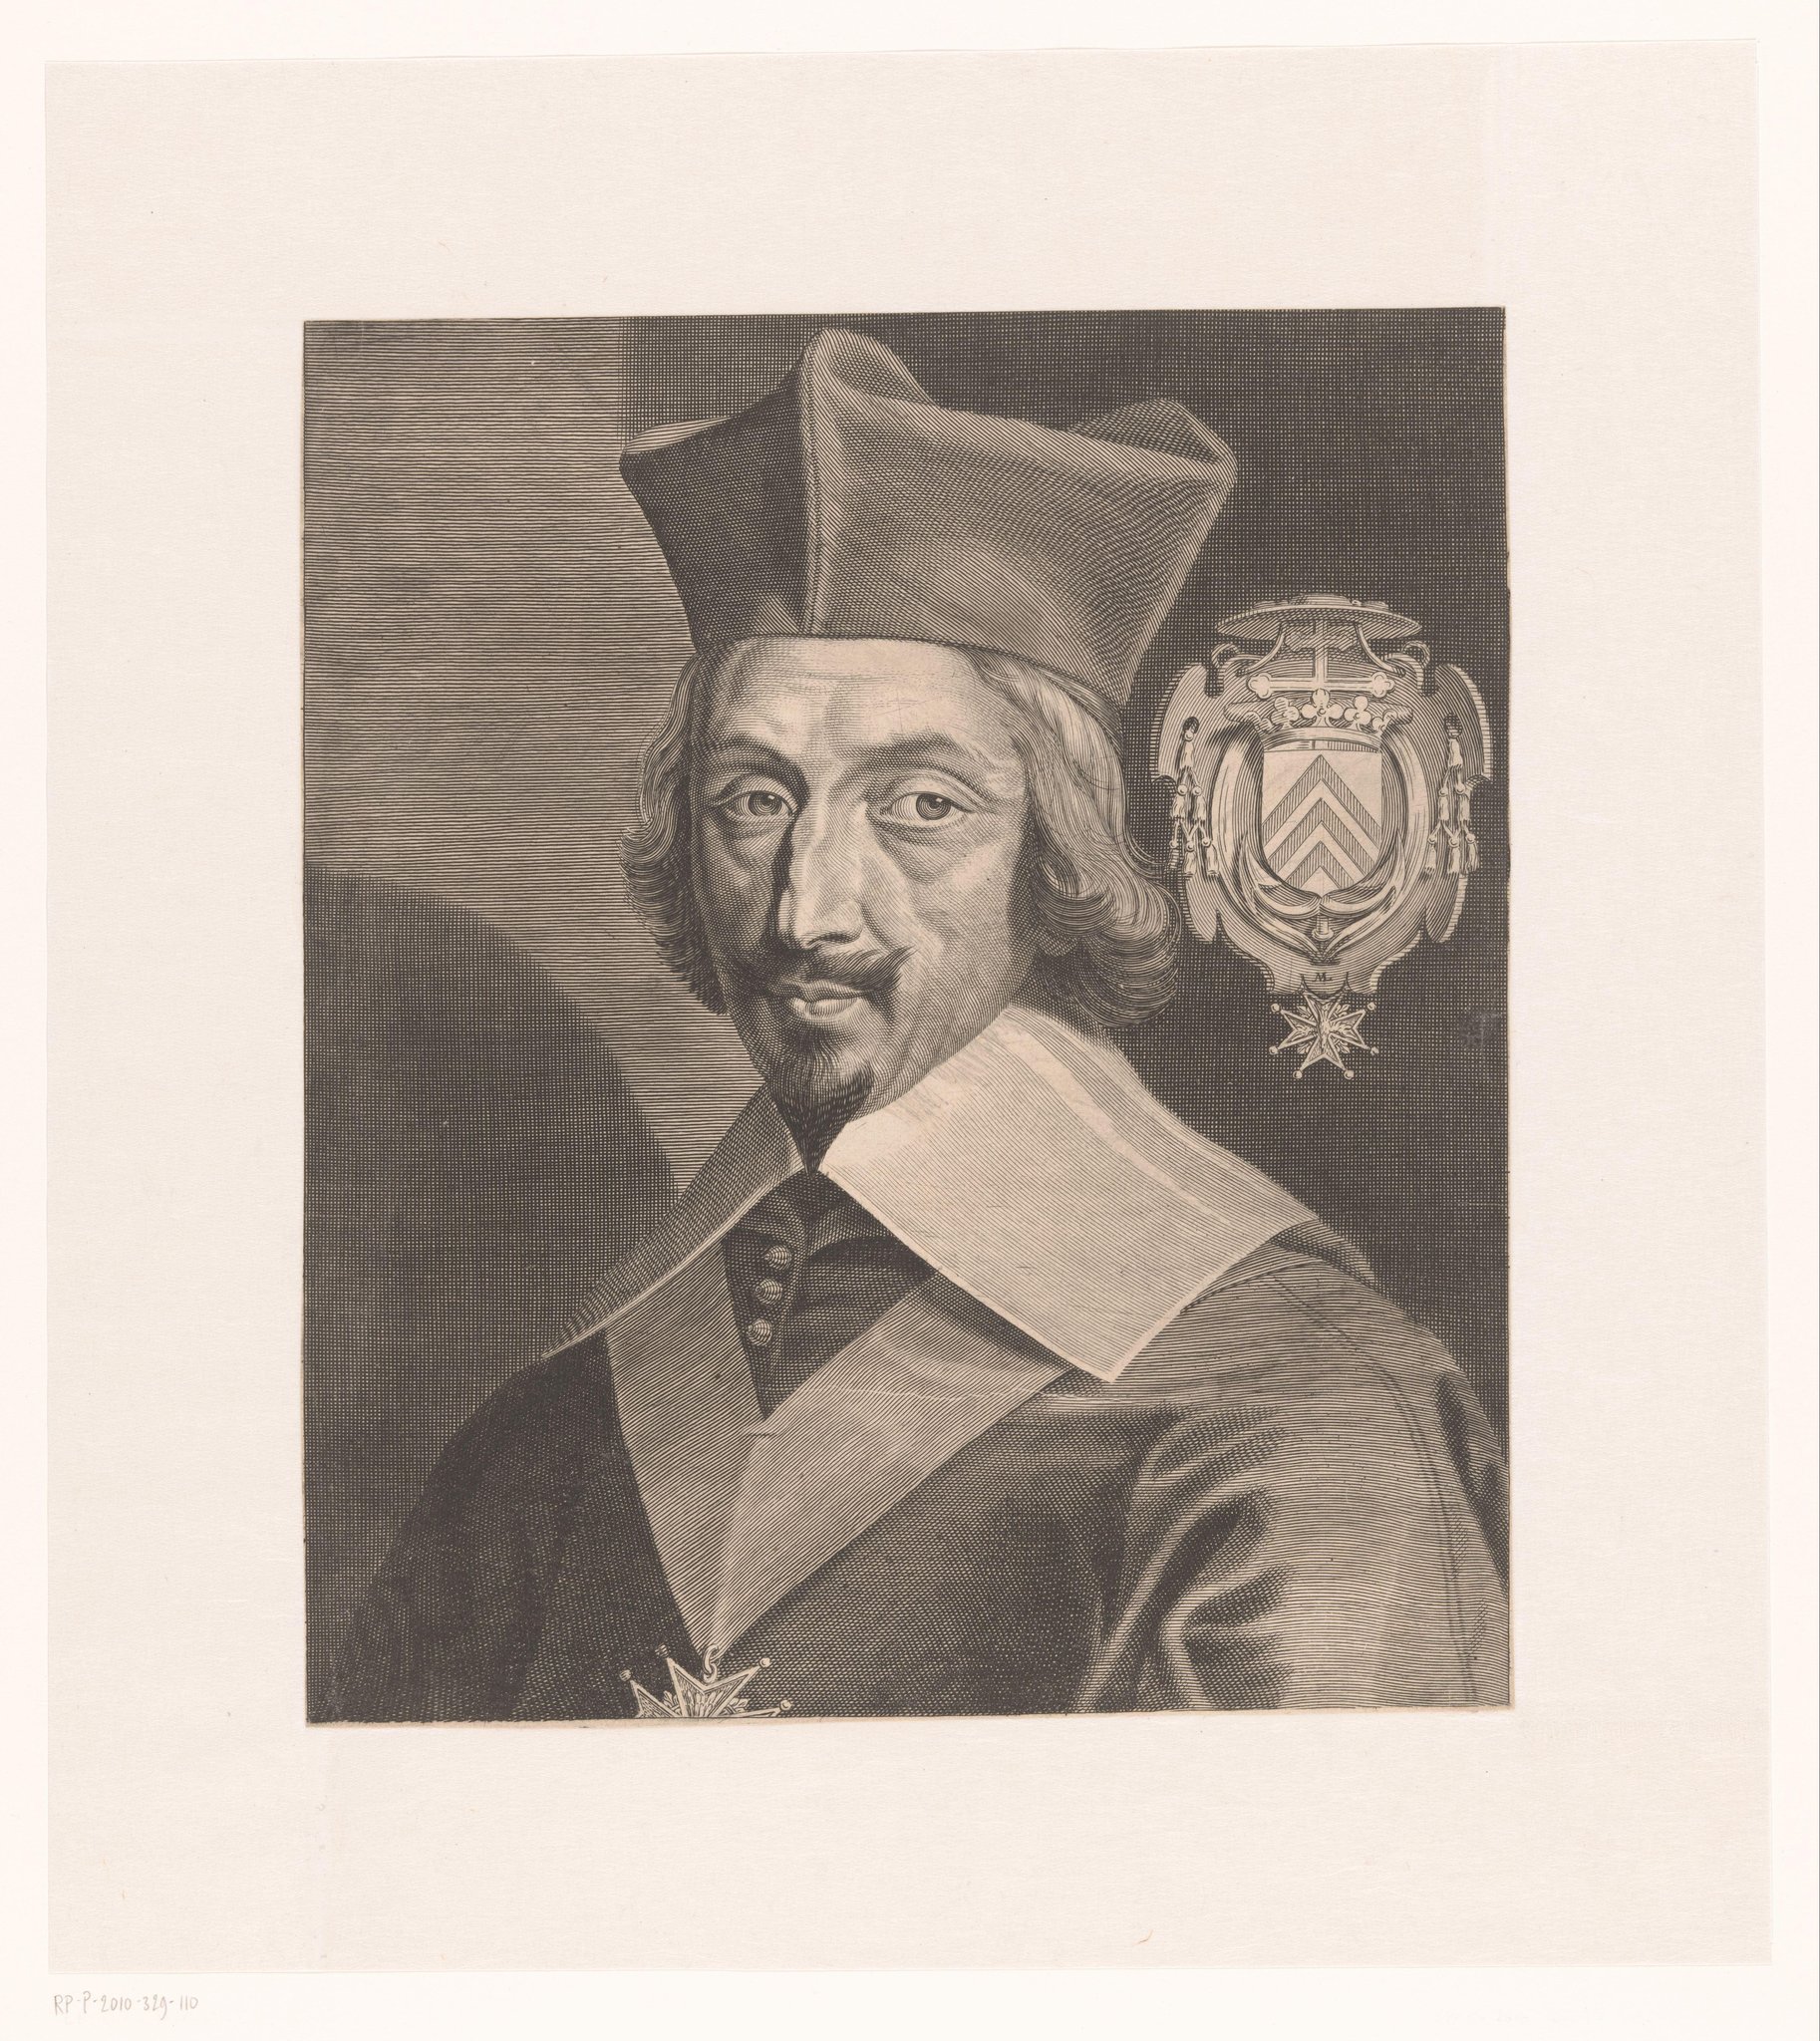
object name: print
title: Portrait of Armand Jean du Plessis, Duke and Cardinal de Richelieu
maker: michel lasne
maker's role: print maker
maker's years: 1590-1667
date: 1633-1667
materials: paper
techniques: engraving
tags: paris, armand-jean du plessis hertog van richelieu, cardinal, historical persons, armorial bearing, heraldry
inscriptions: collector's mark: Lugt 2228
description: The printmaker Michel Lasne trained in the workshop of Rubens. However, the master did not find Lasne’s interplay of lines sufficiently dynamic for translating his paintings into prints. His taut style, however, did appeal to the French king Louis XIII and he was even appointed court engraver. In this capacity, Lasne engraved numerous portraits of members of the French court.